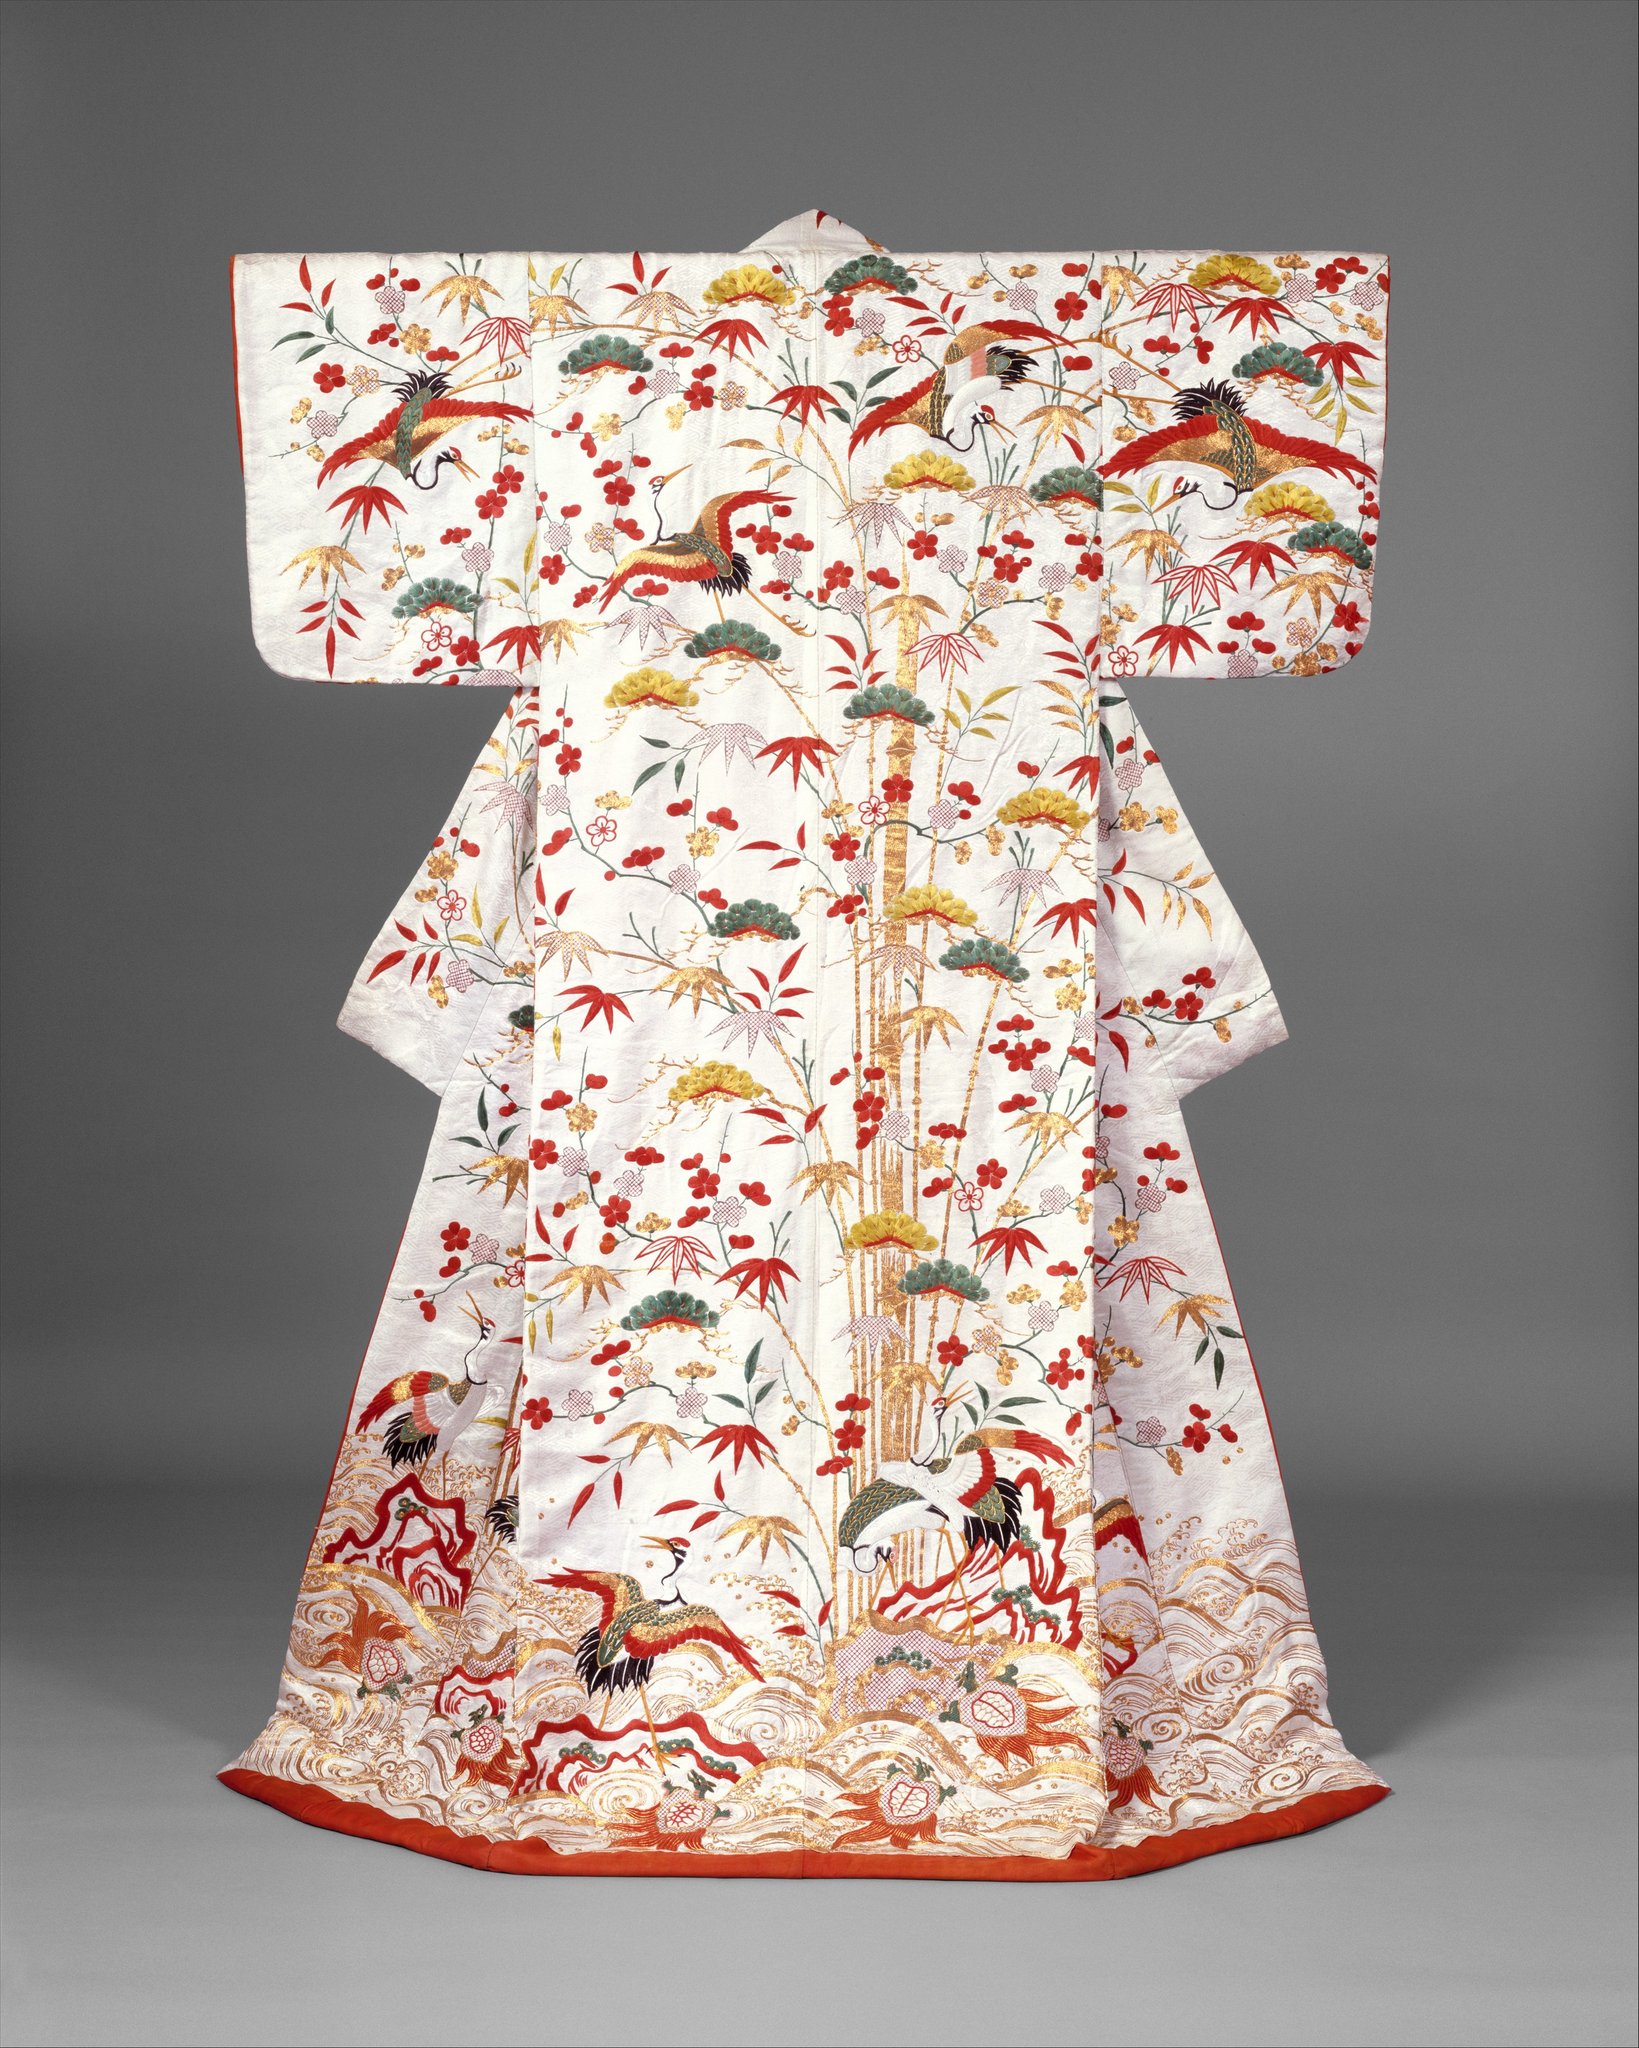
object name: woman's robe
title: Outer Robe (Uchikake) with Mount Penglai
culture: japanese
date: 1767-1800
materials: gold thread, paste, silk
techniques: dyeing, embroidery, resist, satin weave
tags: cranes,flowers,plants,bamboo